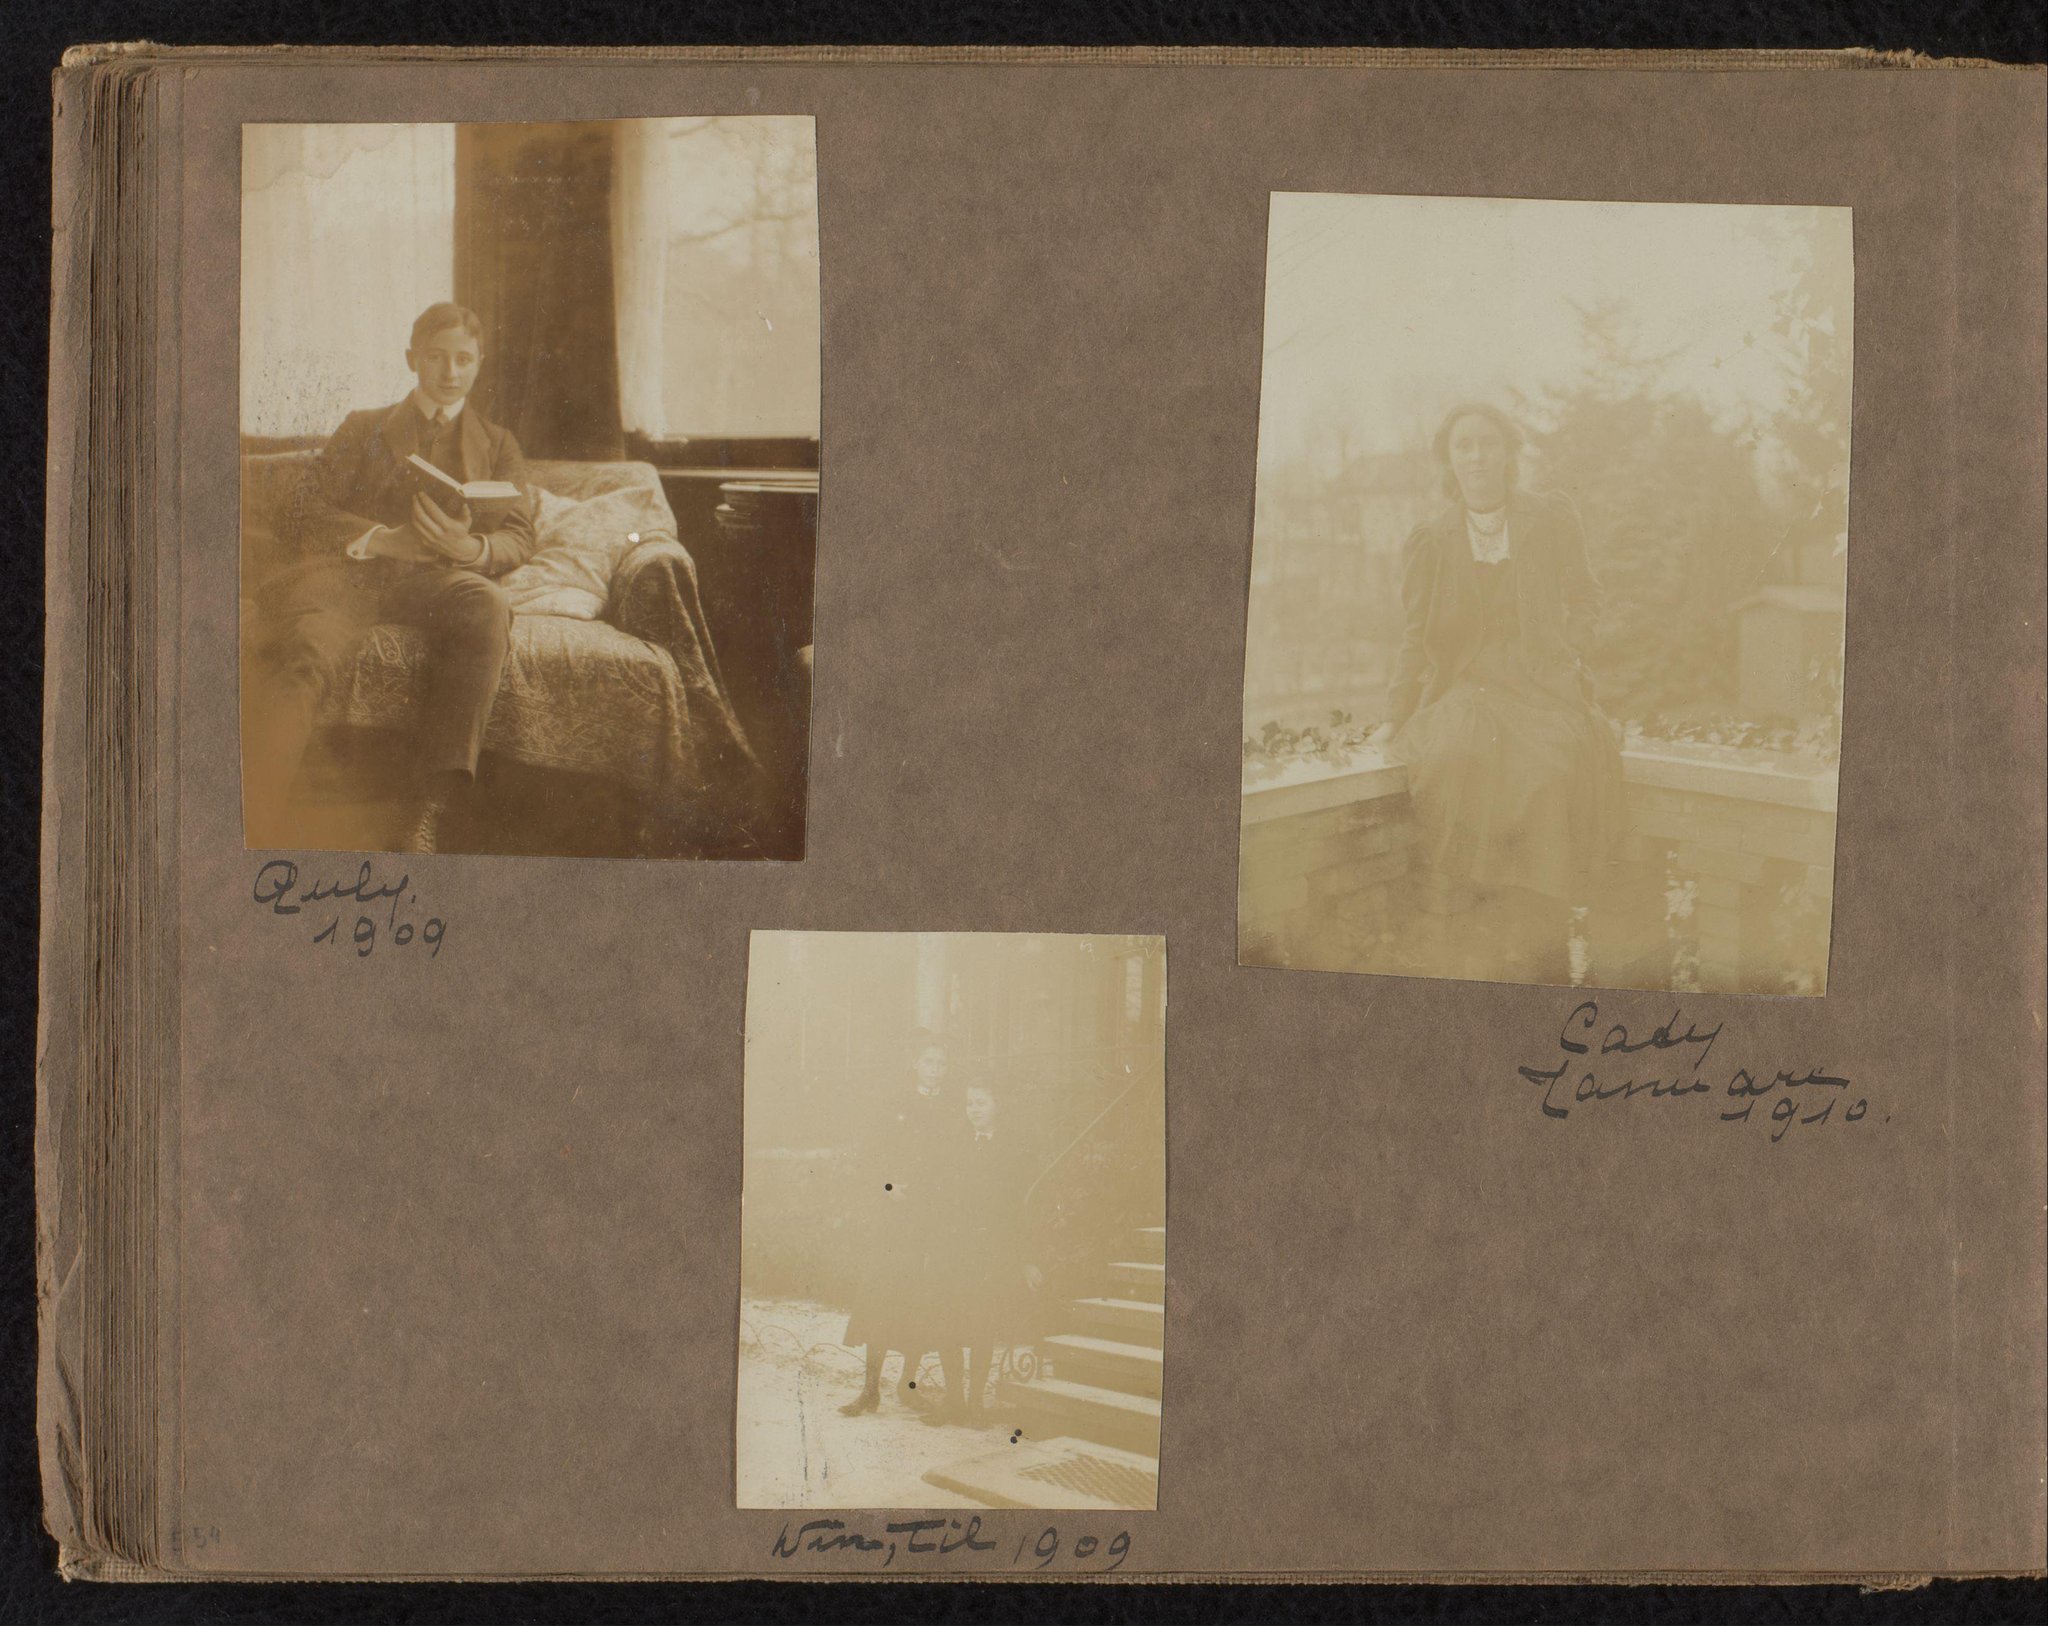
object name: album leaf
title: Drie portretten van Guly Boissevain, Caty van den Wall Bake en anderen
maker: carolina frederika onnen (lien/loen)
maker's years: 1896-1983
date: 1909-1910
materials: paper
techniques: gelatin silver print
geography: hilversum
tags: reading, historical persons, friends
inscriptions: inscription: ‘Caty/ Januari 1910’, inscription: ‘Guly,/ 1909’, inscription: ‘Win, Til 1909’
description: Deze foto's maken deel uit van een album.